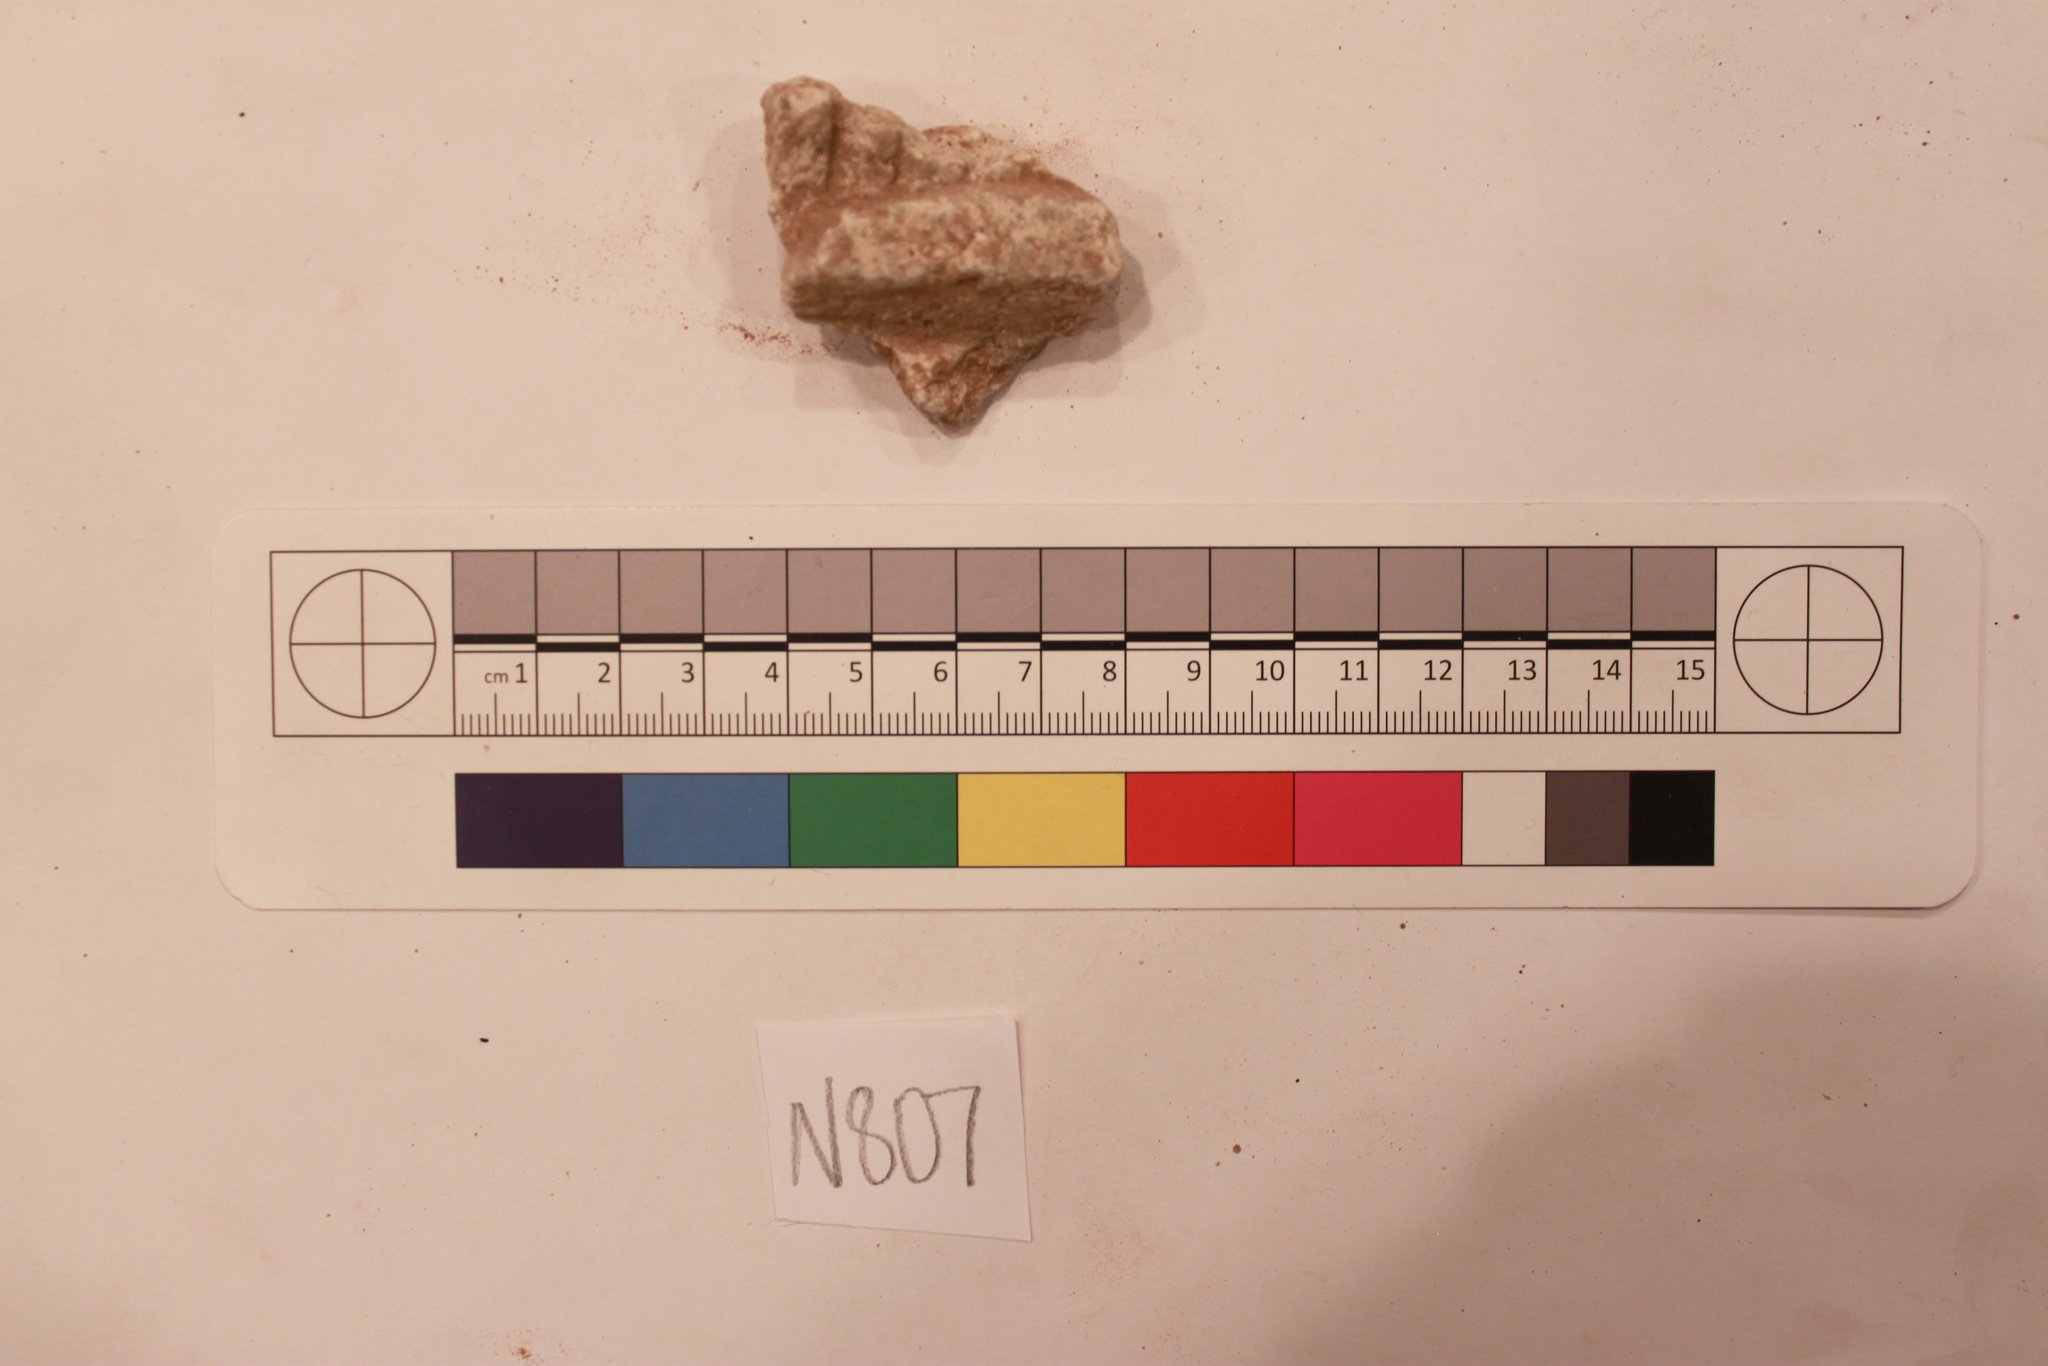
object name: fragment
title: Stucco Fragment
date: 701-1200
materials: plaster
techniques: carving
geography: iran